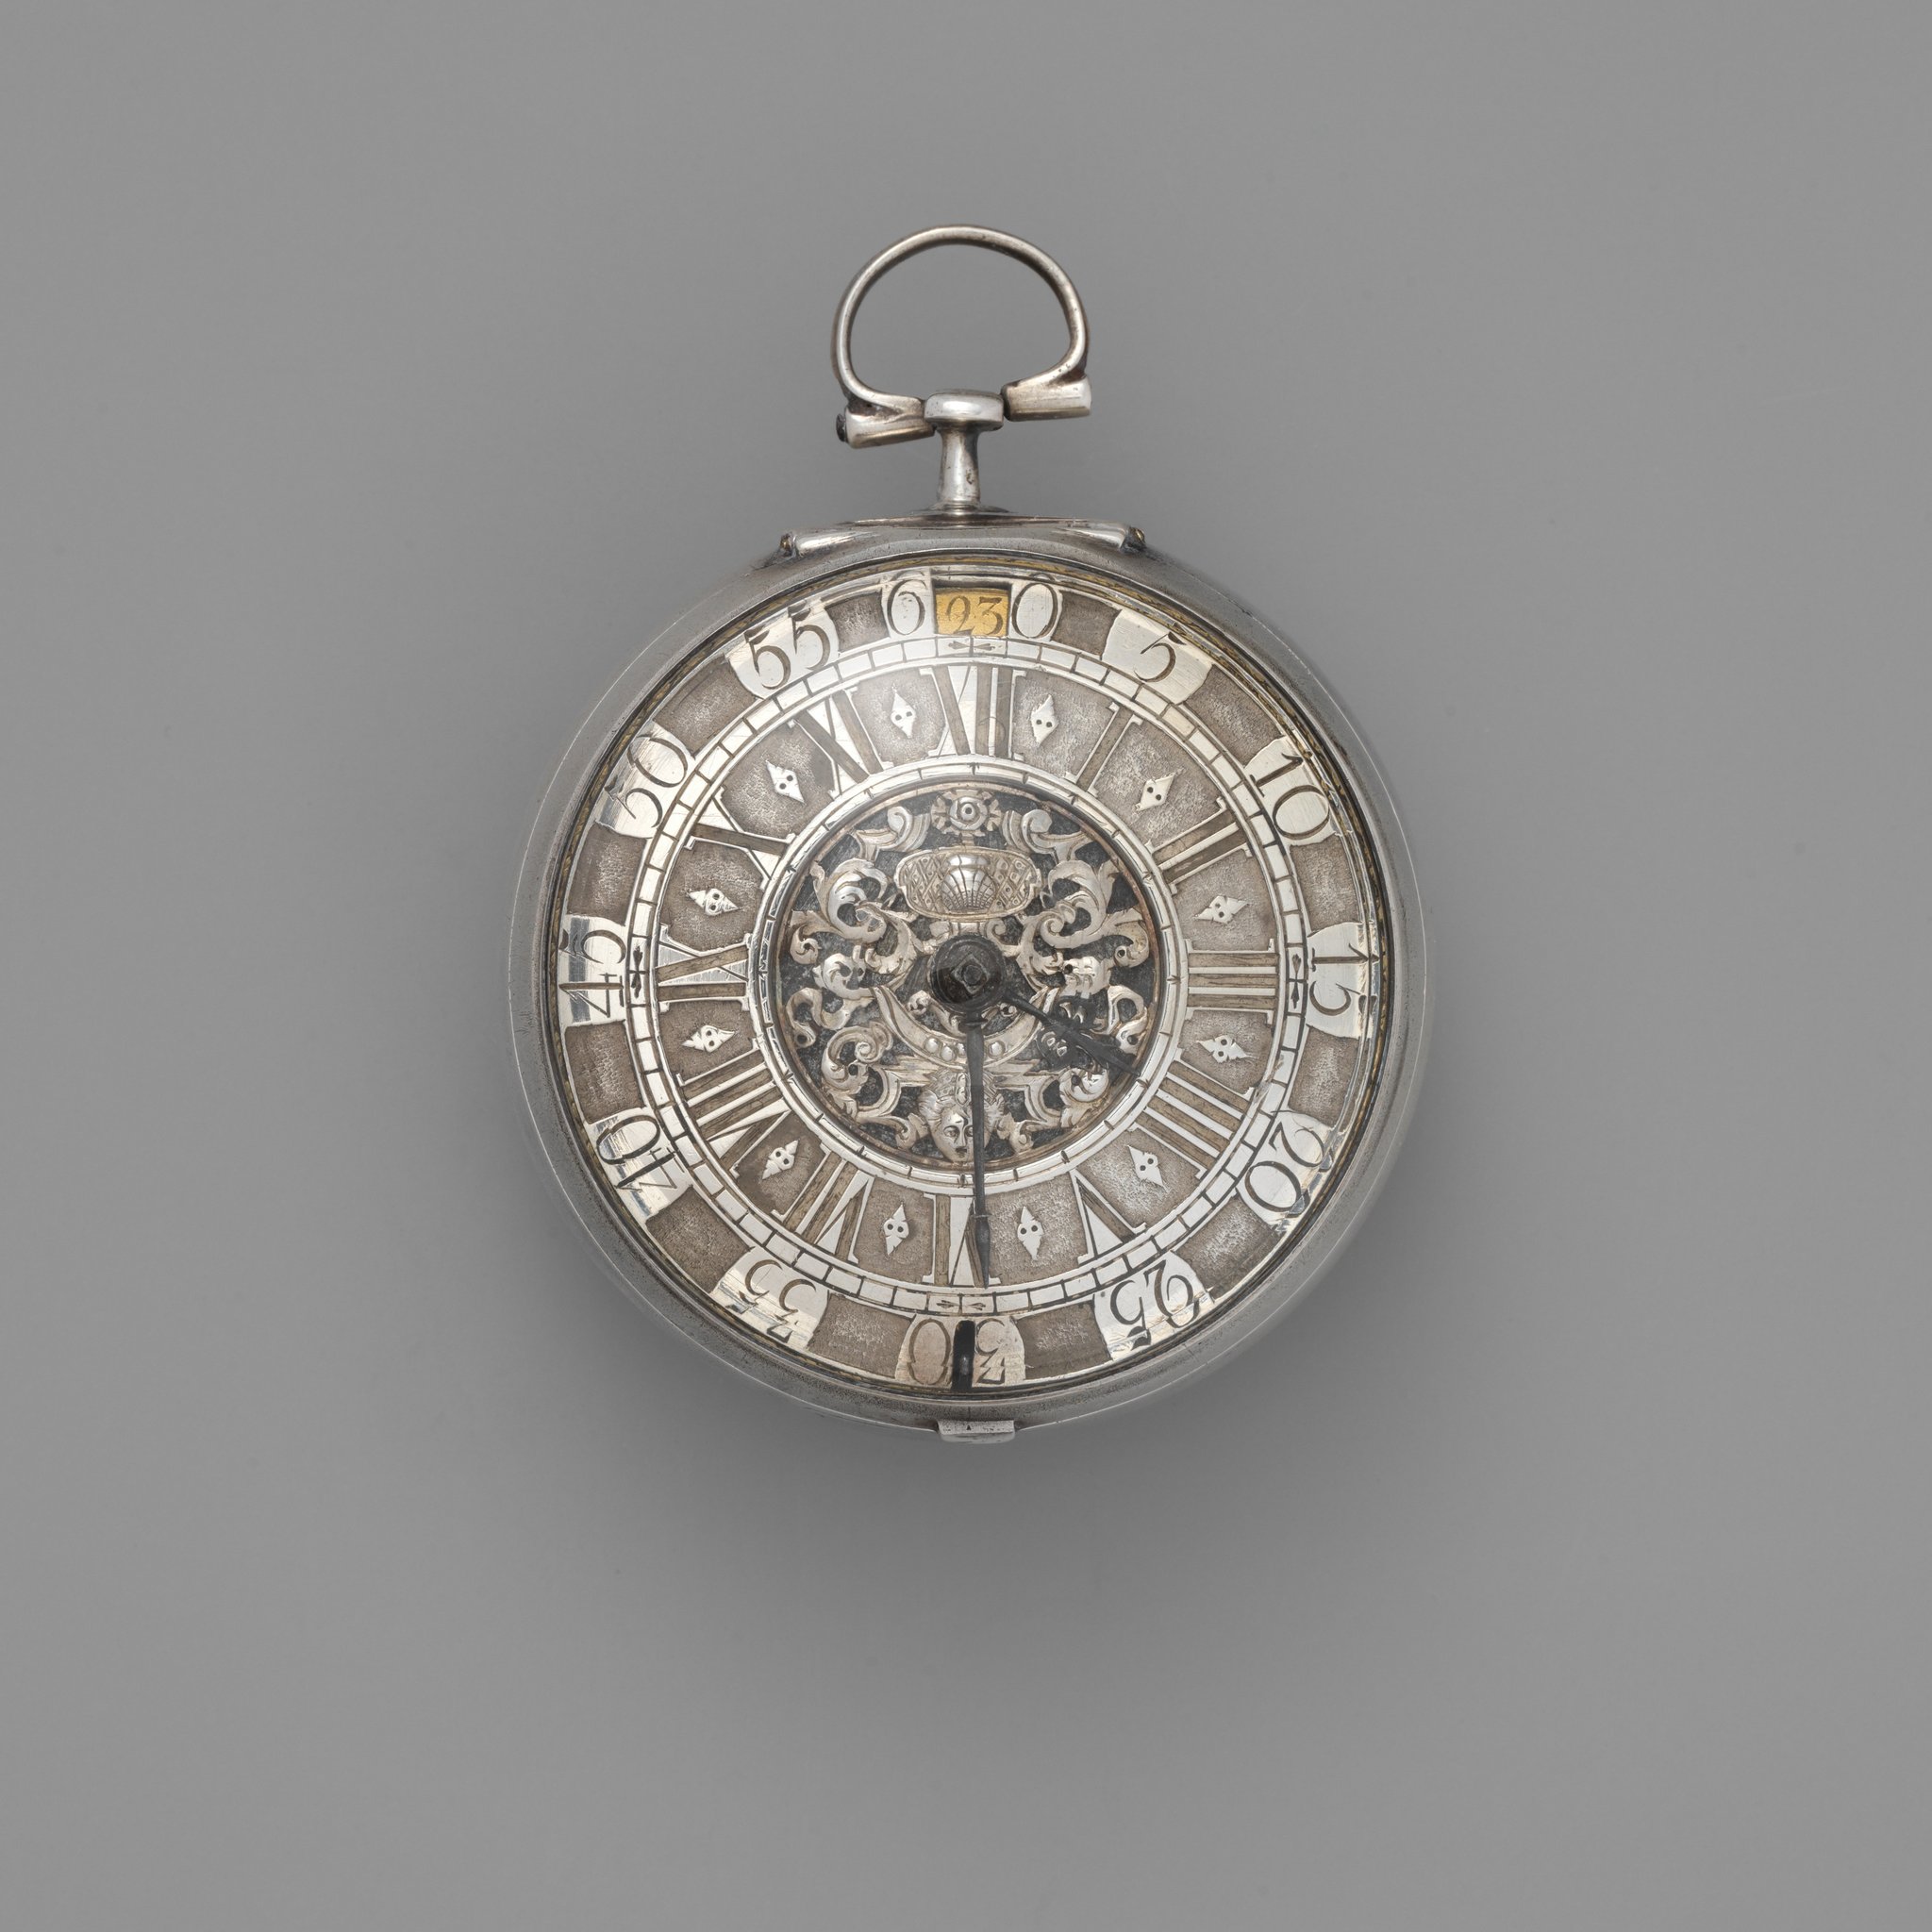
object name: calendar watch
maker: gabriel-joseph moillet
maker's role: maker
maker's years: 1681-1757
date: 1726-1750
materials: silver